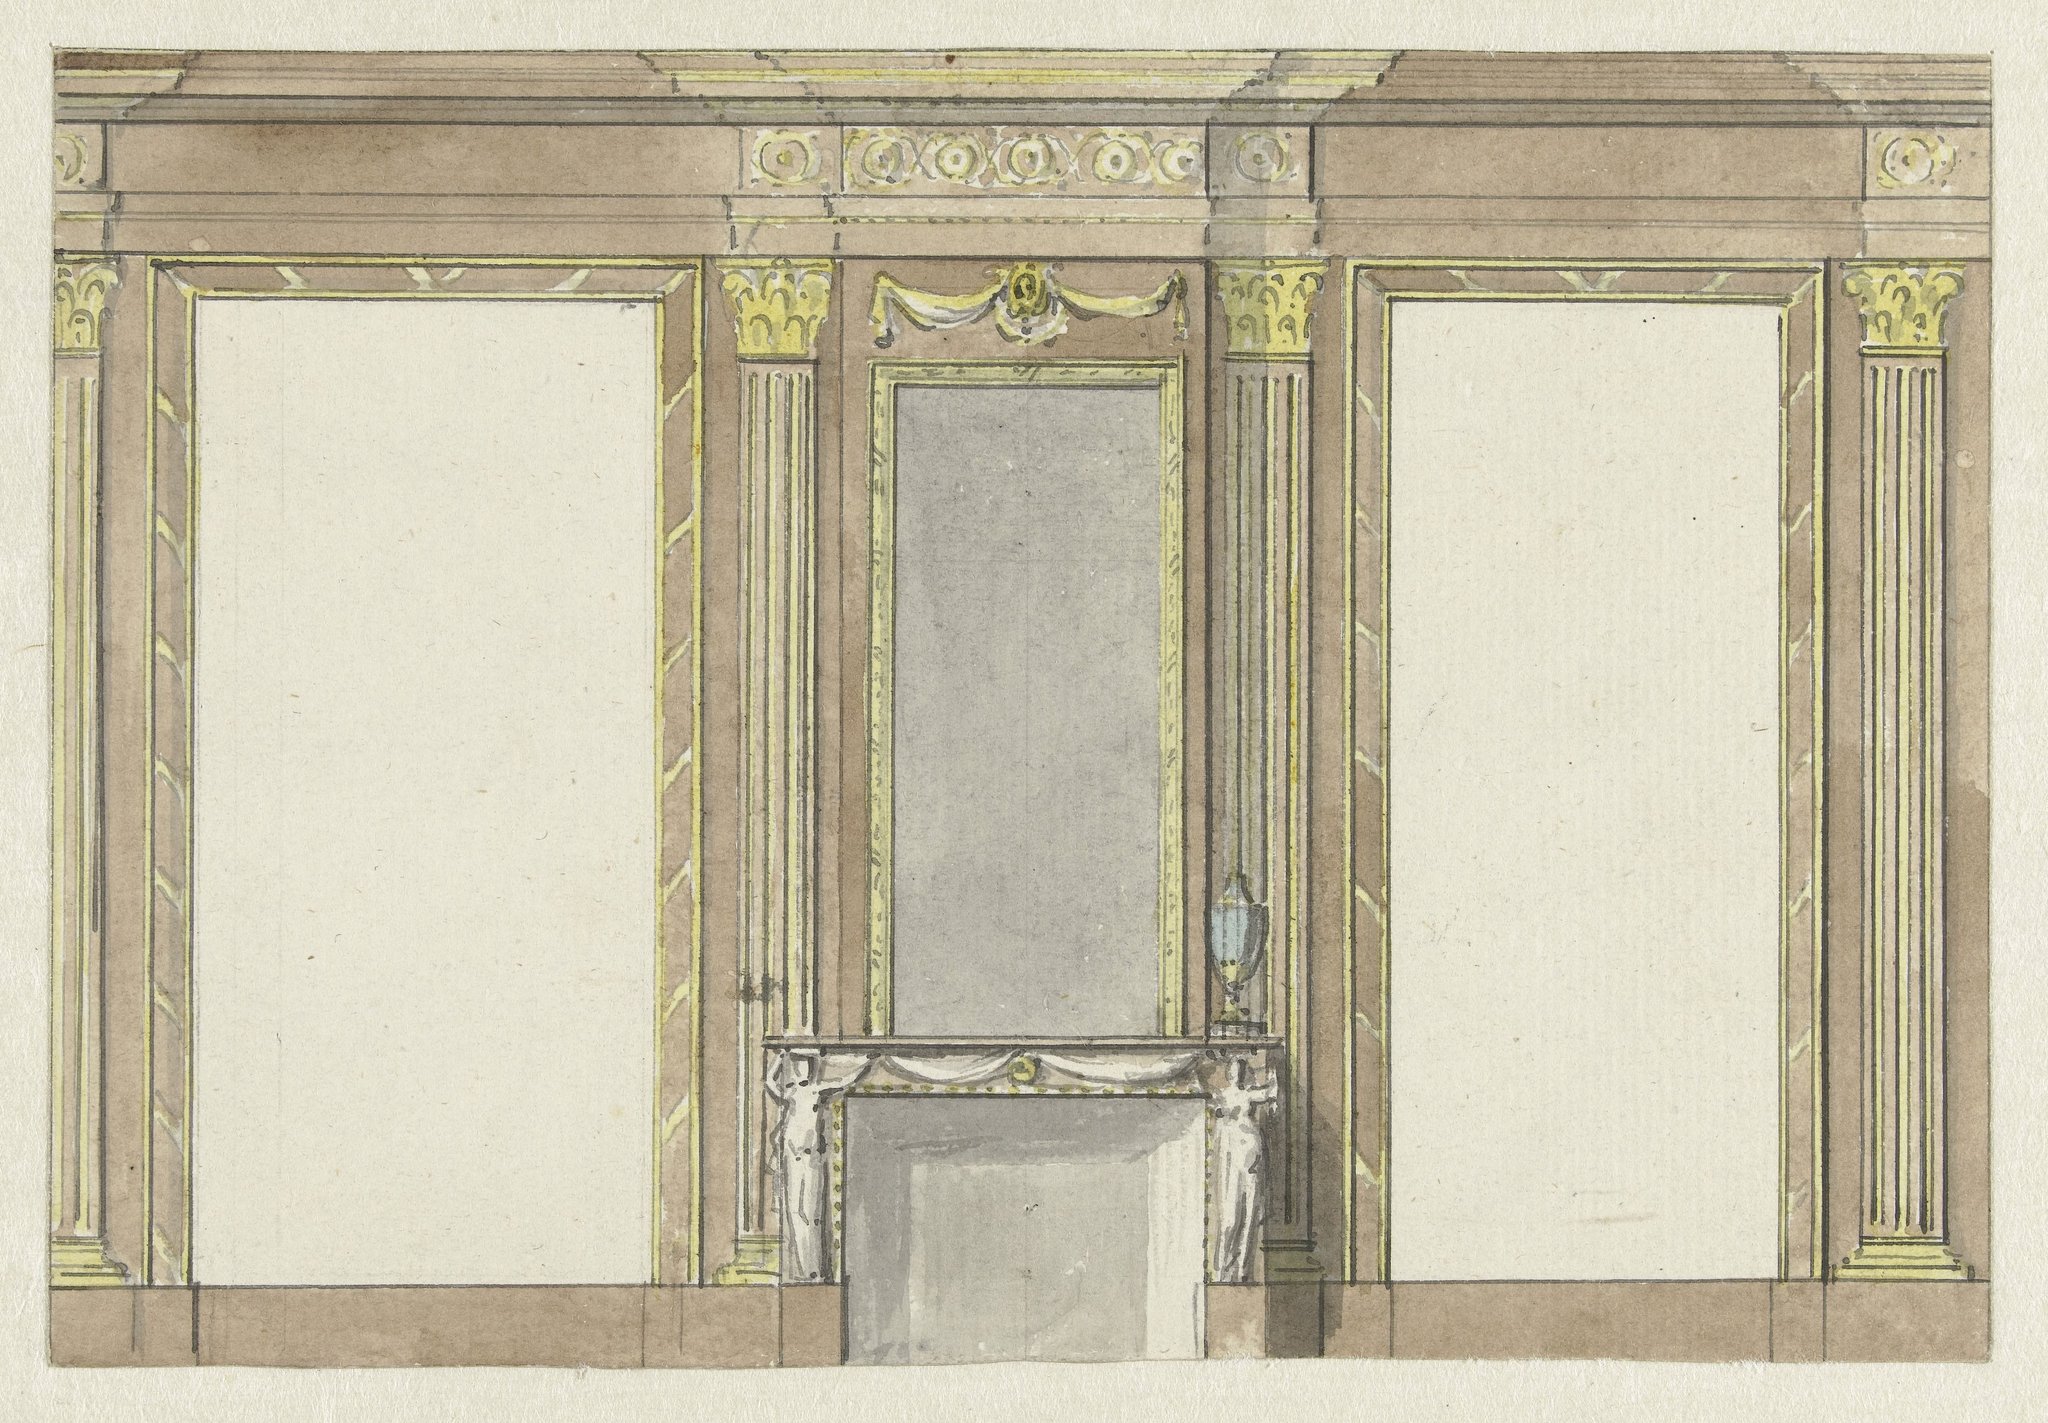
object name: drawing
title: Ontwerp voor behangschildering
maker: jurriaan andriessen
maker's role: draughtsman, painter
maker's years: 1742-1819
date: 1752-1819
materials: graphite, ink, paper, watercolor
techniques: brush, pen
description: Ontwerp voor behangschildering (zaal Keizersgracht 105, Amsterdam).